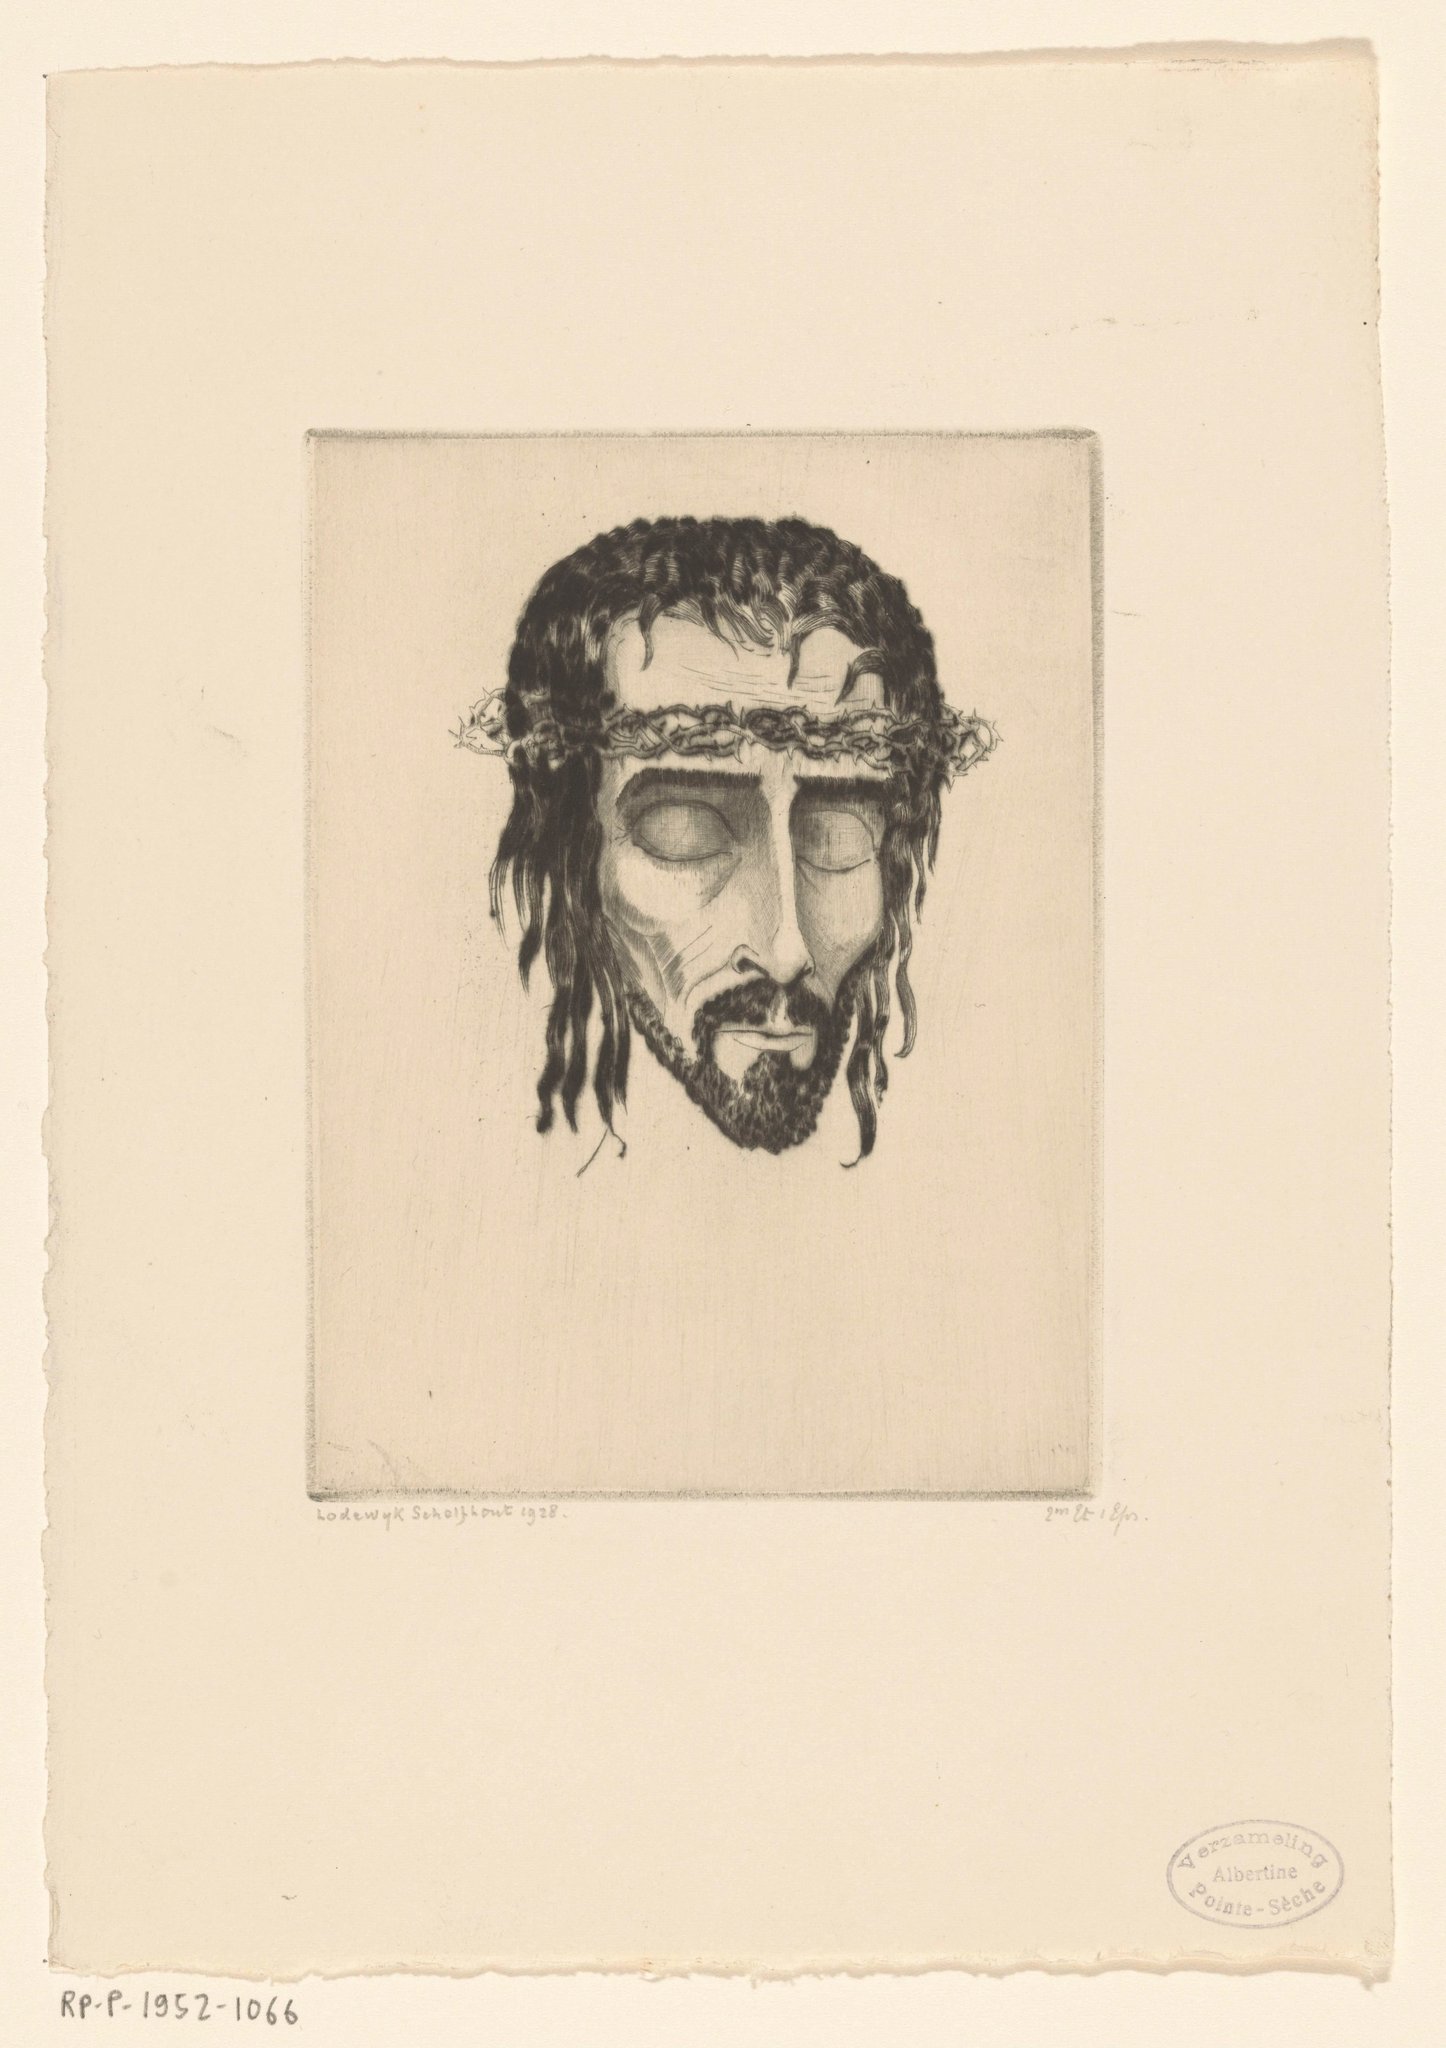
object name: print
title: Tête de Christ IV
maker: lodewijk schelfhout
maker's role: draughtsman, print maker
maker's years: 1881-1943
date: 1928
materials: paper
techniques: drypoint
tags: crown of thorns ~ instruments of the passion, eyes closed, 'portraits' of christ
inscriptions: collector's mark: Lugt 5i, collector's mark: Lugt 2228